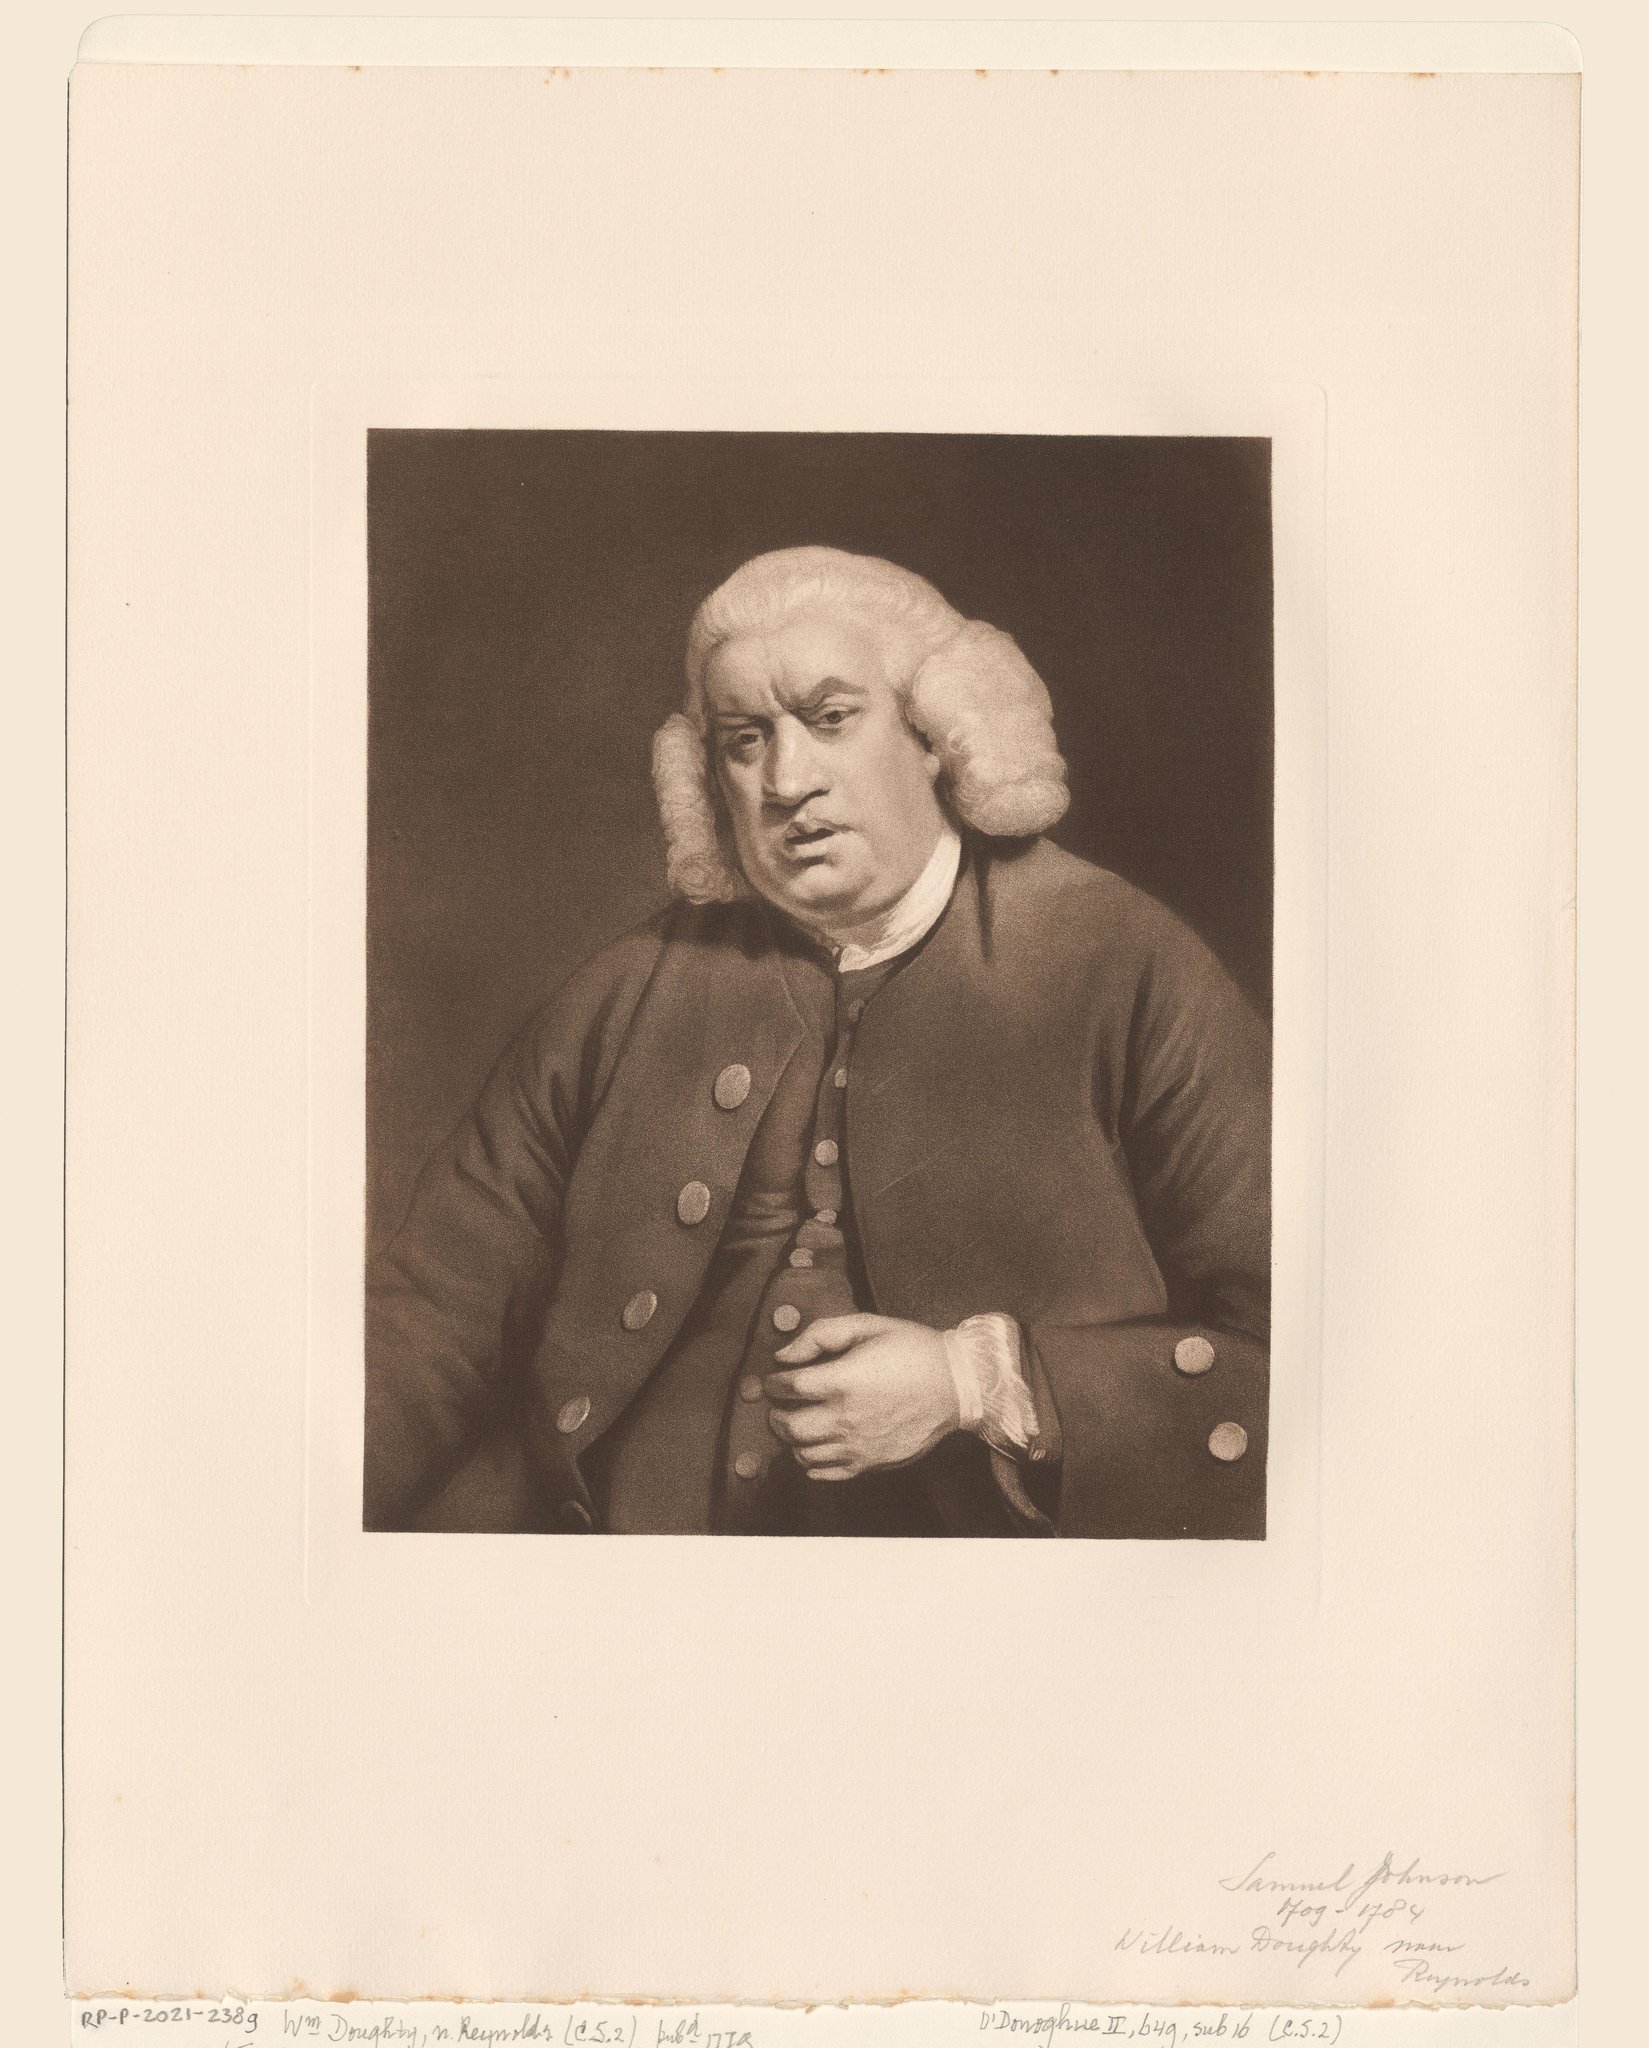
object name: photomechanical print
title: Portret van Samuel Johnson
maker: Anonymous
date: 1870-1900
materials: paper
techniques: photoaquatint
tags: historical persons, portrait of a writer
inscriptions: collector's mark: Lugt 2228